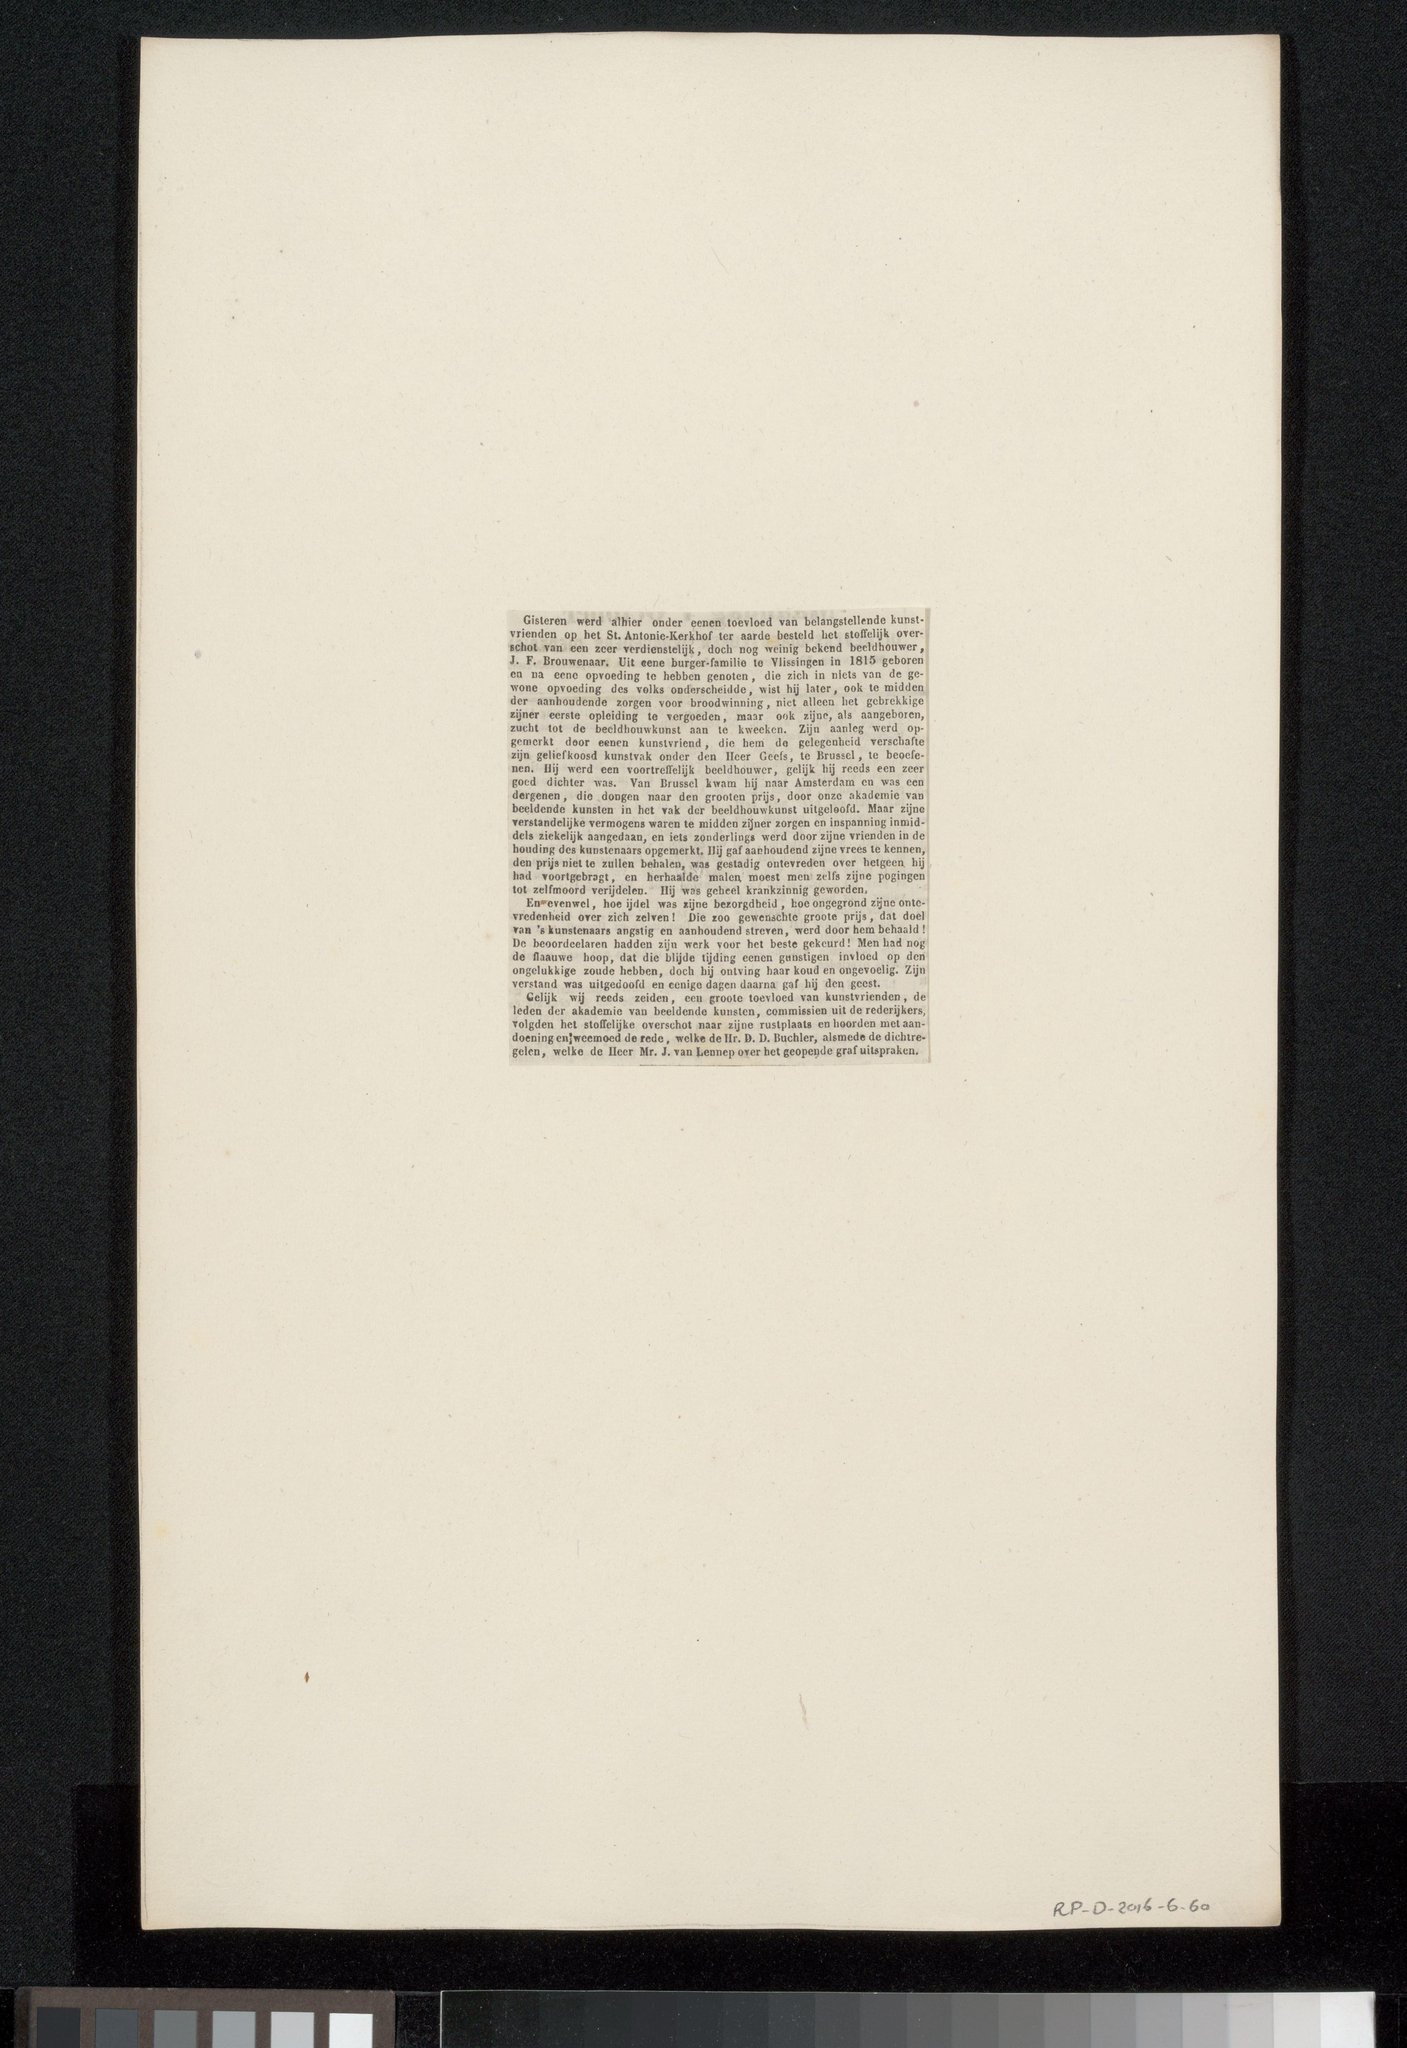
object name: newspaper clipping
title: Krantenknipsel betreffende Jan François Brouwenaar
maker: Anonymous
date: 1849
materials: paper, ink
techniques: printing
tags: flushing, sculptor